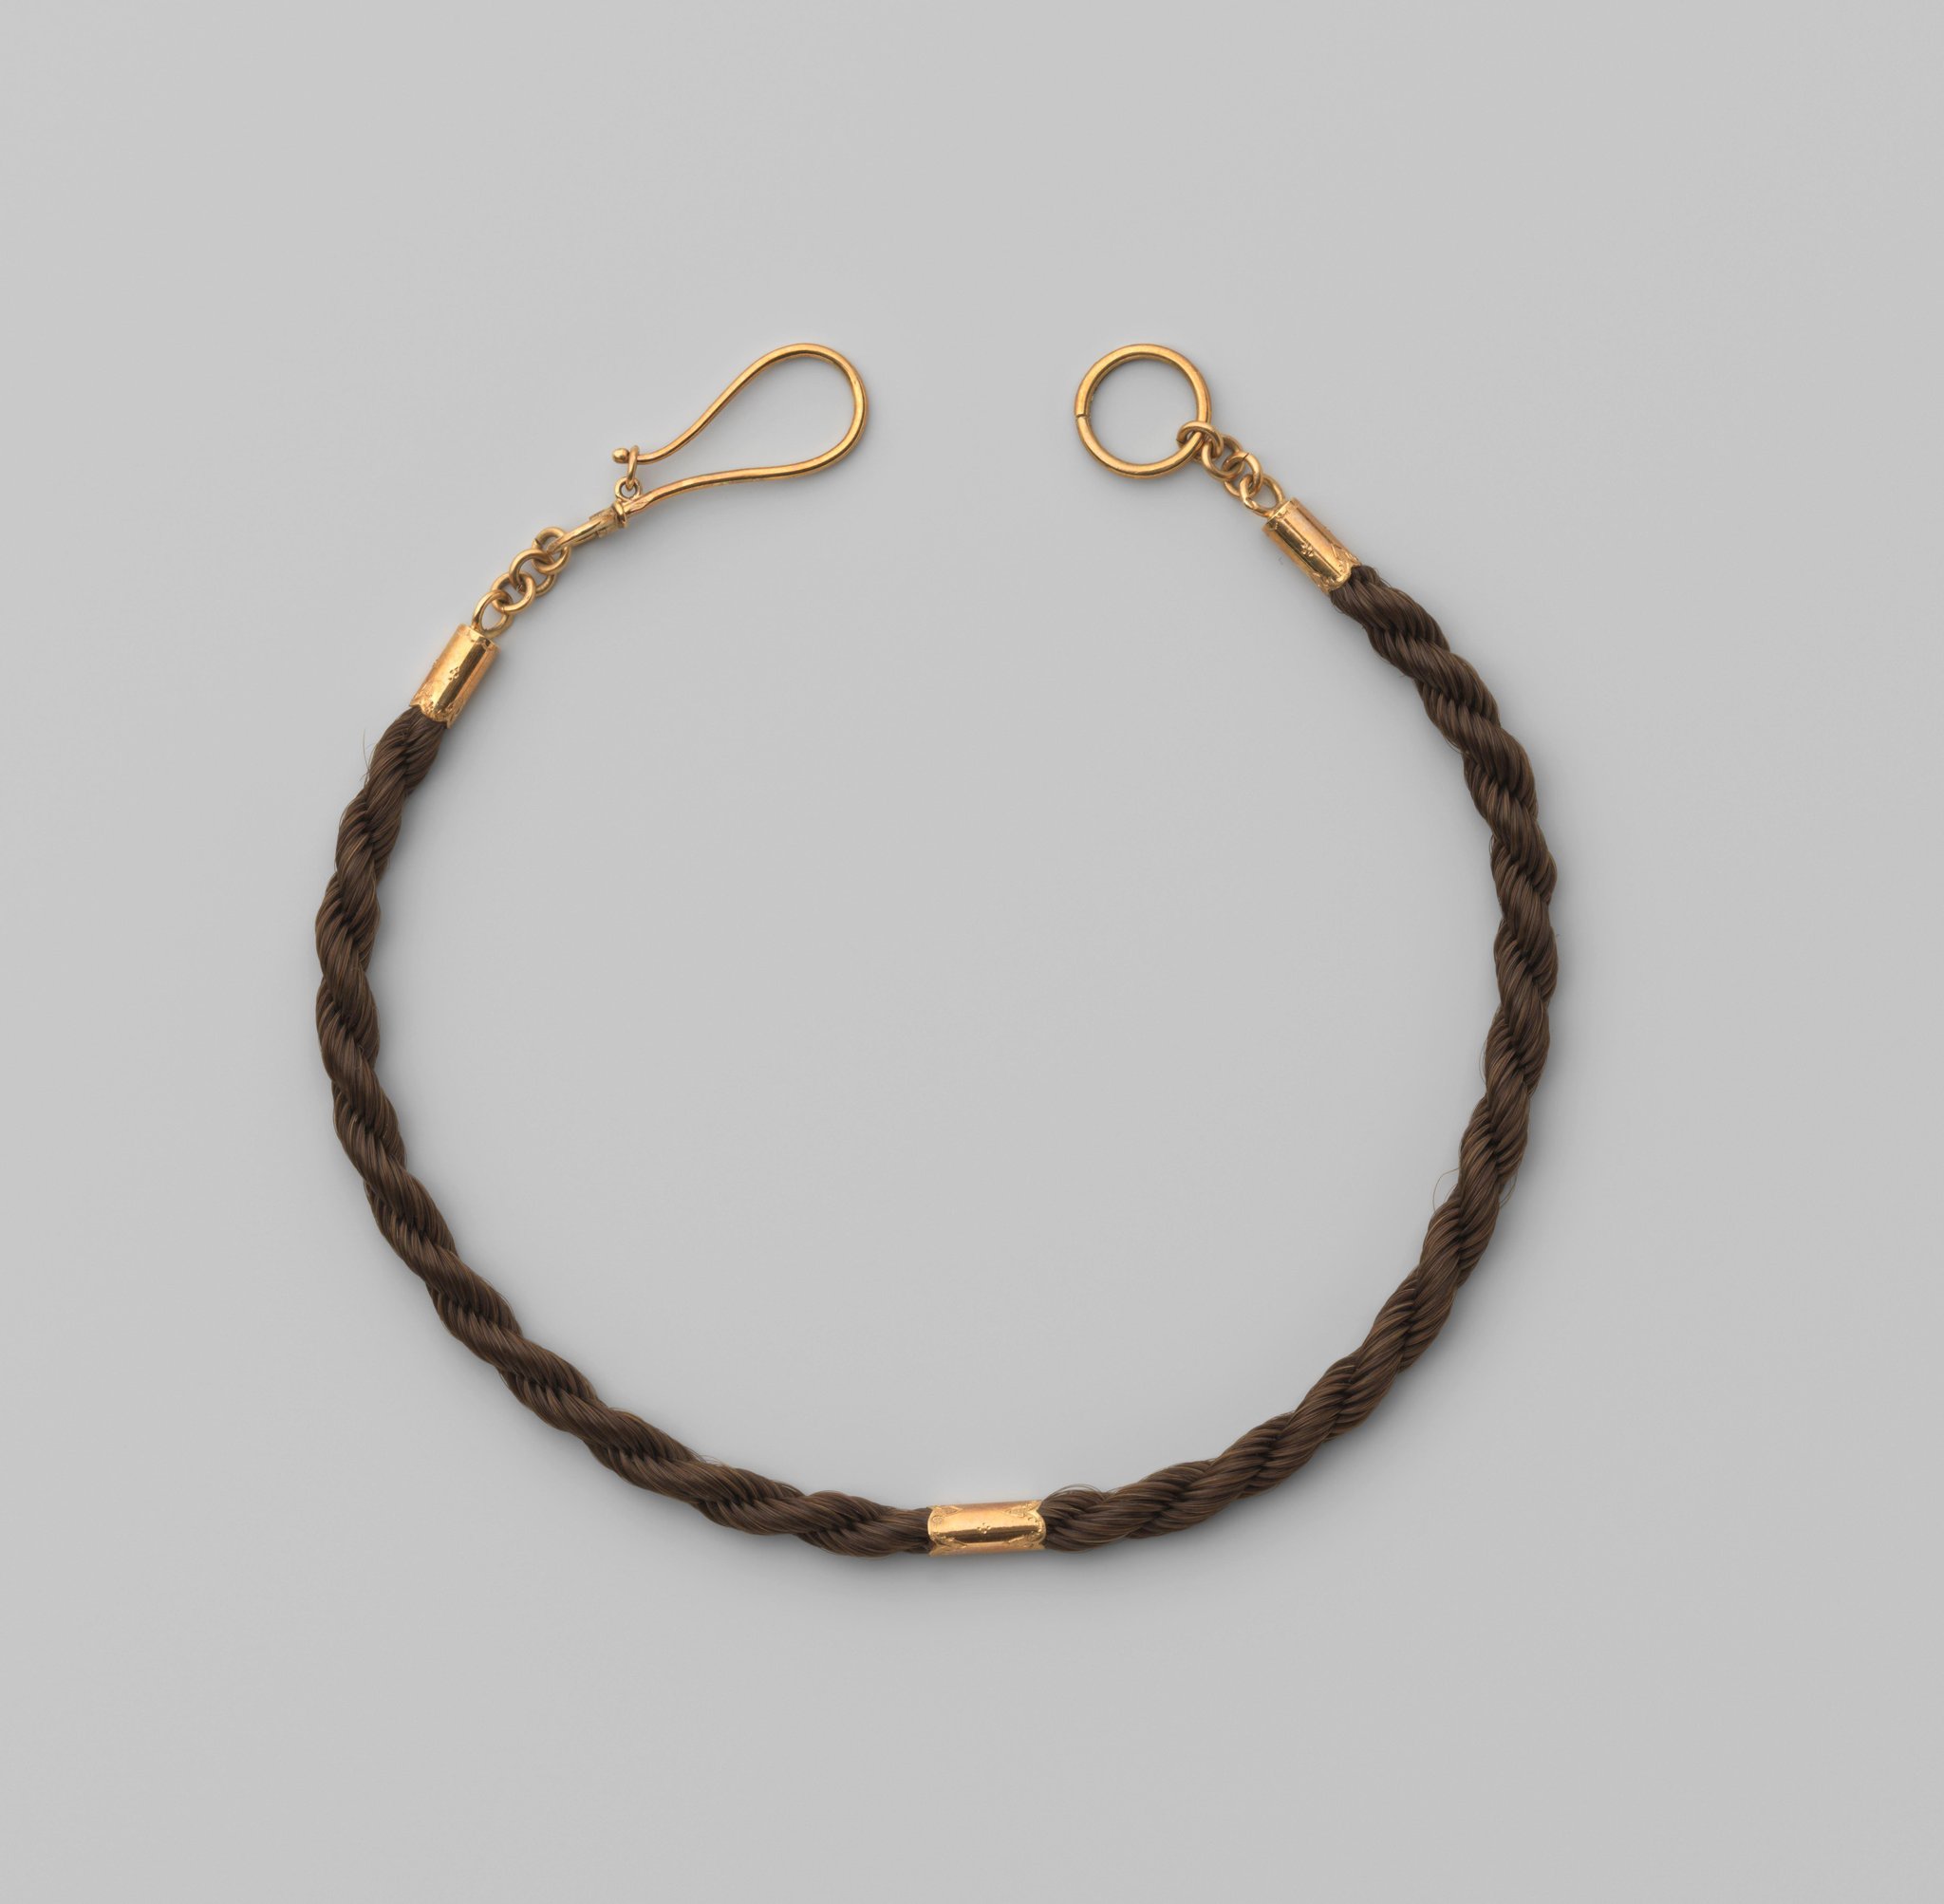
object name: chatelaine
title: Horlogeketting van haar en goud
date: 1845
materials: gold, hair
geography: amsterdam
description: Heren-horlogeketting van bruin haar en goud in een groen, rond doosje. Gemaakt van een korte dubbele kabel. Gevat in goud. Gemerkt met een eikeblaadje.